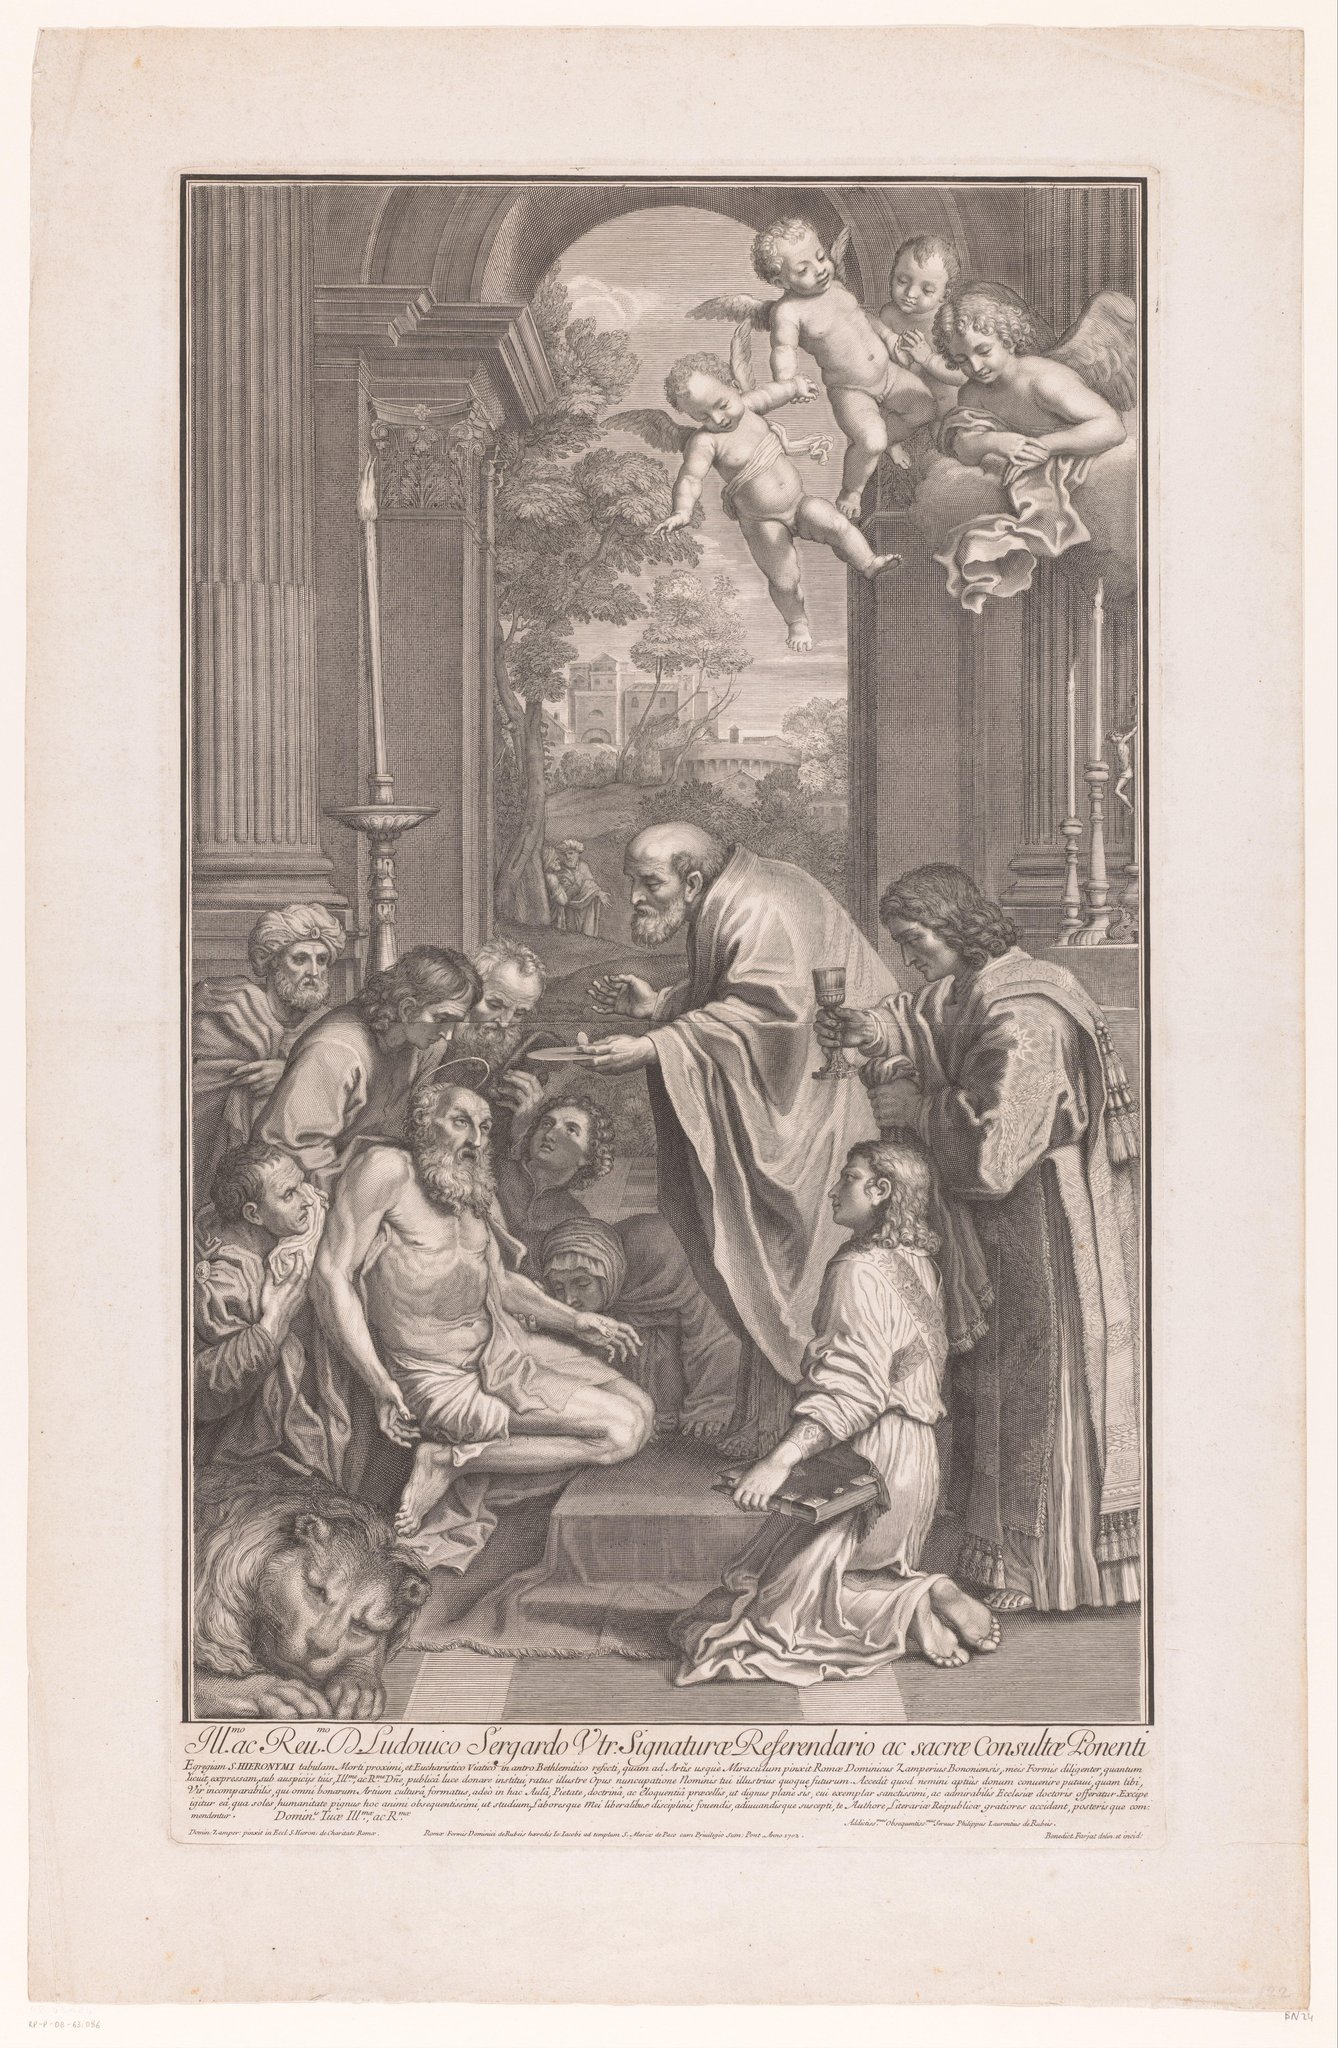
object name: print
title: Communie van H. Hieronymus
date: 1702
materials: paper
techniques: engraving, etching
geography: rome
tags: the last communion of st. jerome: he is attended and supported by younger priests, one of whom is about to administer the sacrament; usually st. paula is present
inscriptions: collector's mark: Lugt 240